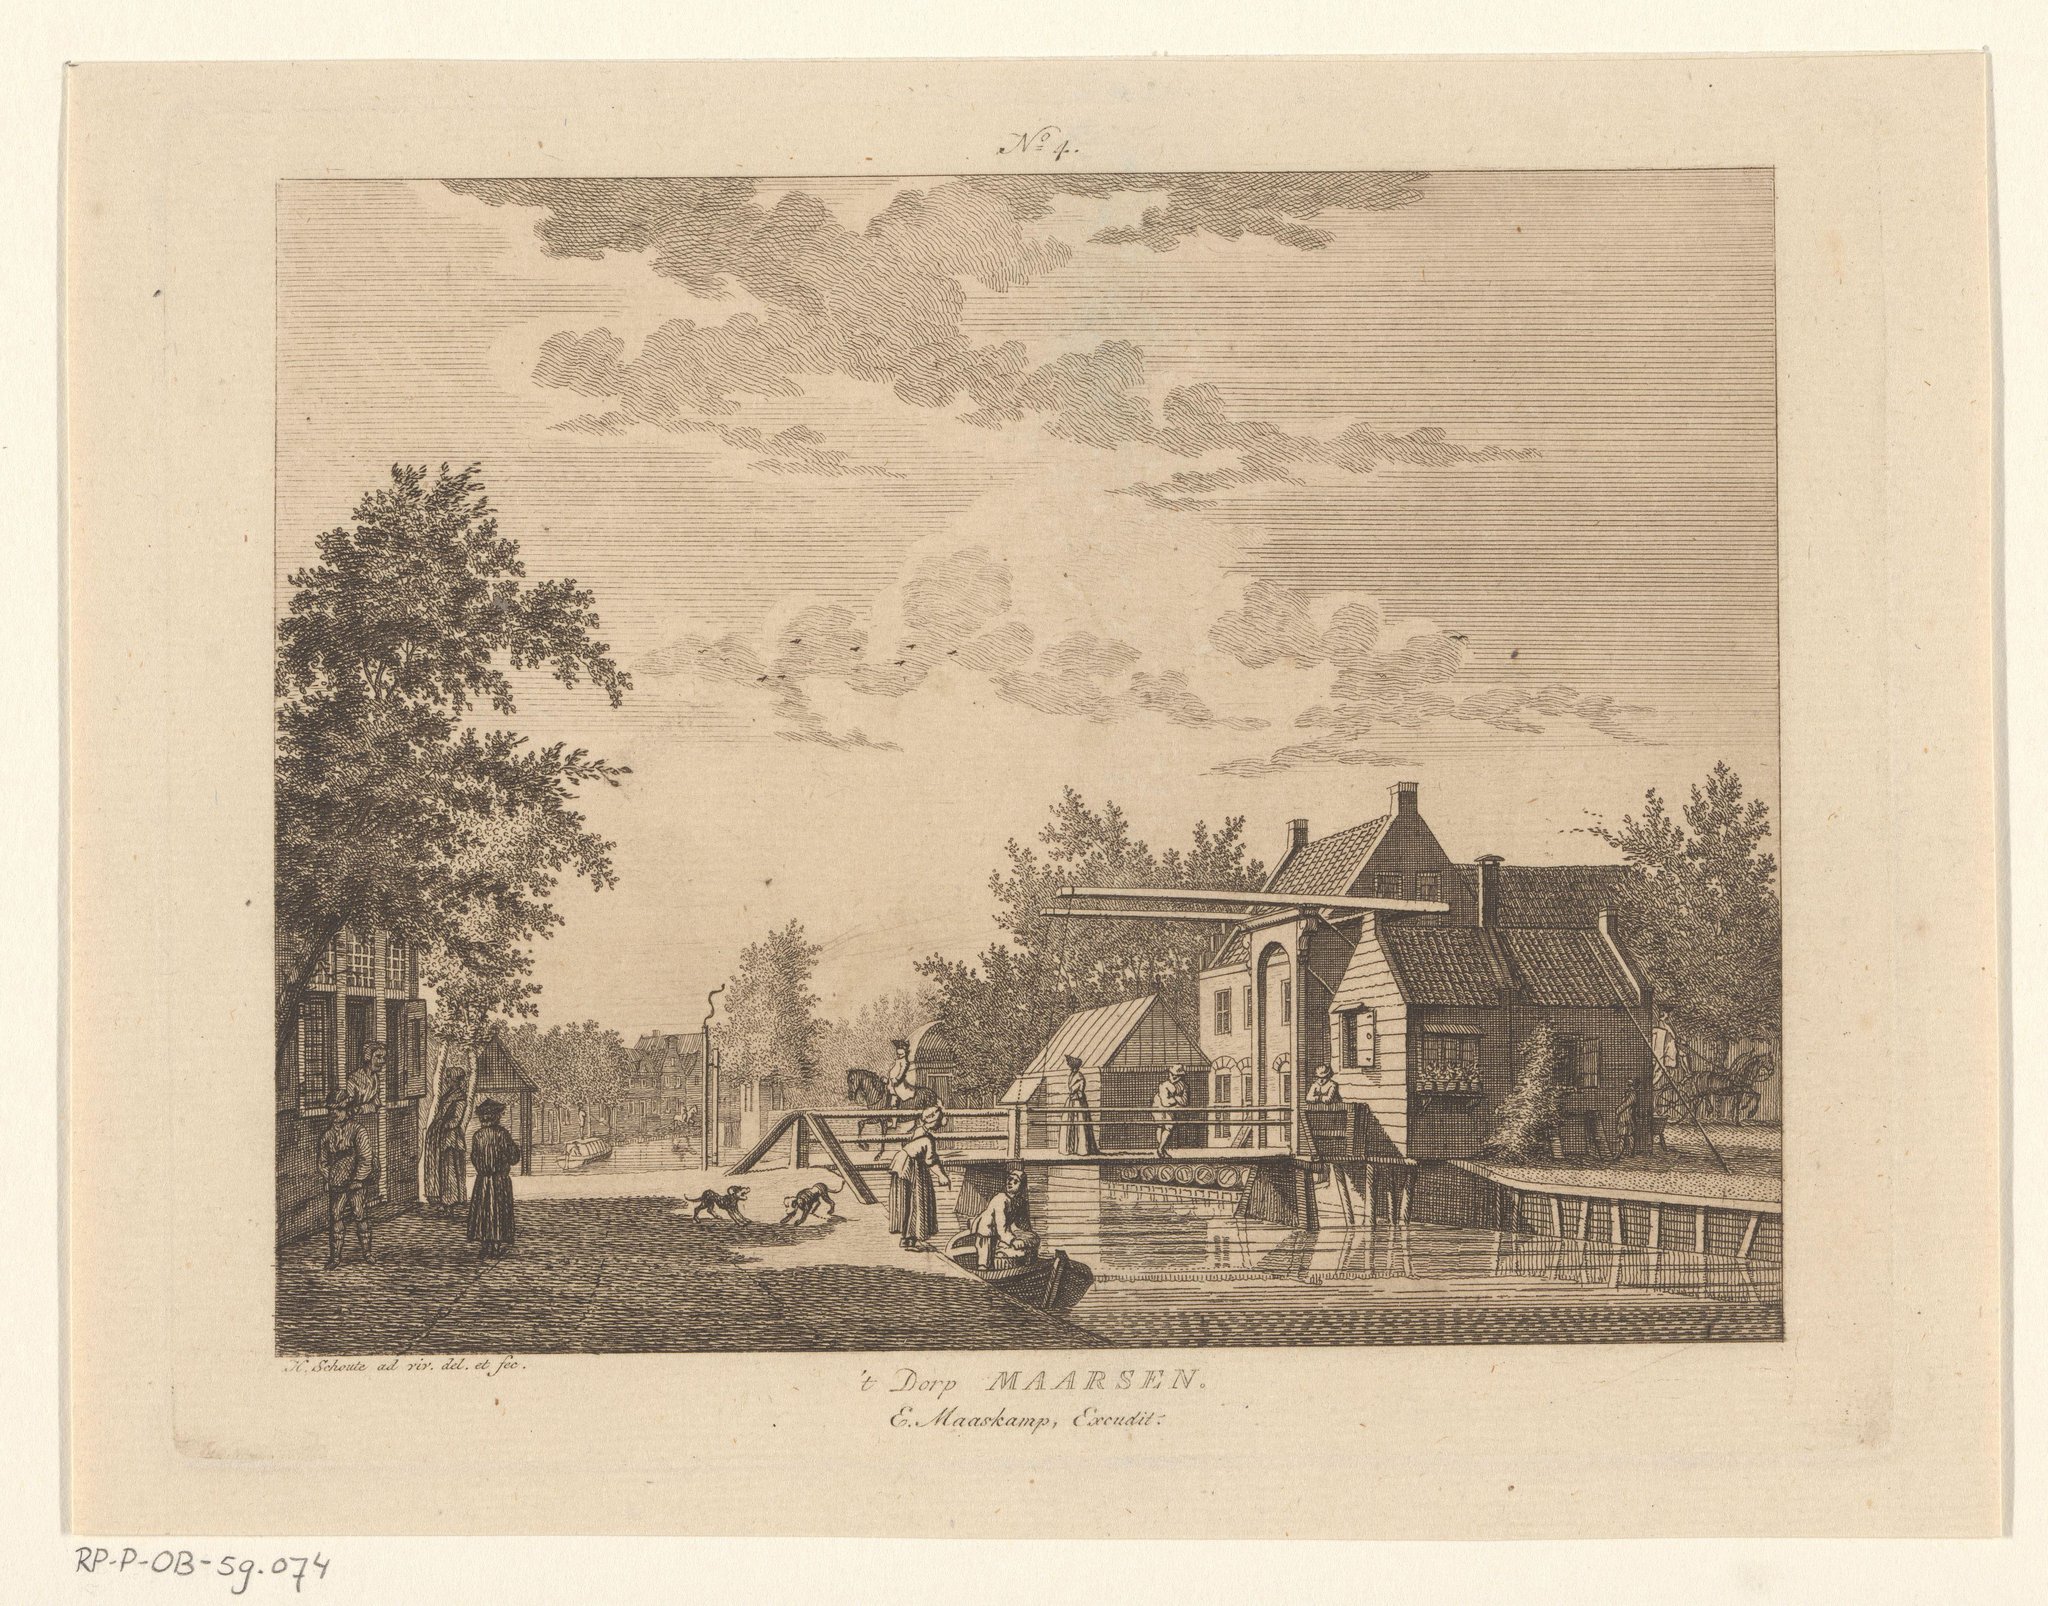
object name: print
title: 't Dorp Maarssen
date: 1795-1805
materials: paper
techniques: etching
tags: maarssen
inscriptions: collector's mark: Lugt 2228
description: Prent komt voor in Gezichten voorname hollandse dorpen. Amsterdam, E. Maaskamp, c. 1800.